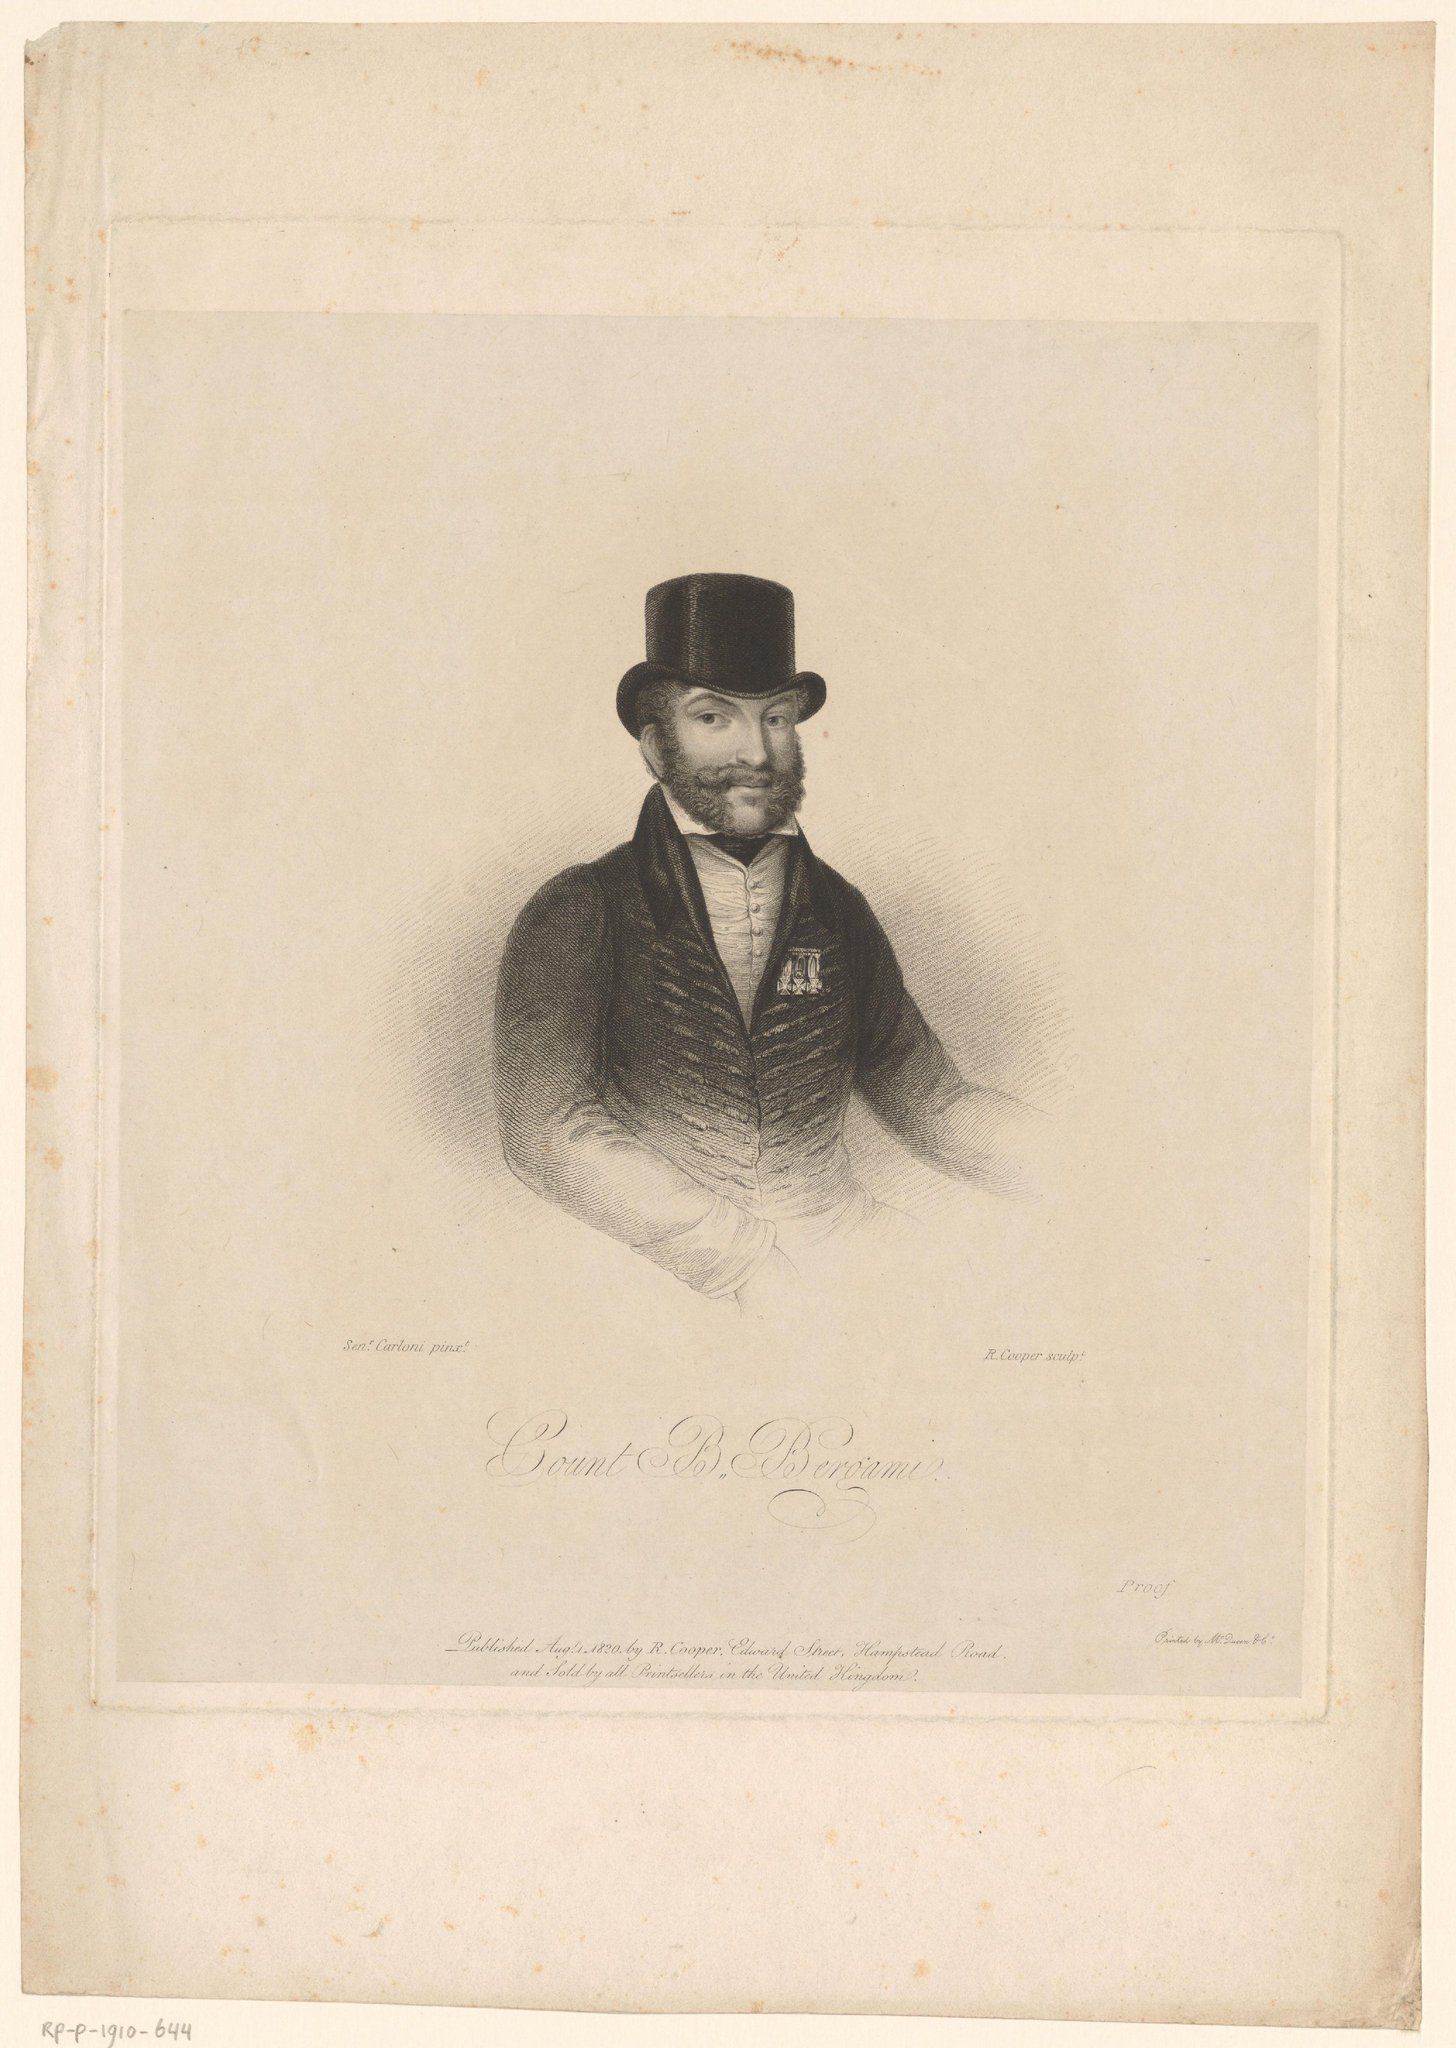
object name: print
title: Portret van Bartolomeo Bergami met hoed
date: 1820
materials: paper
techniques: etching, roulette, engraving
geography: england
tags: earl, historical persons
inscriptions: collector's mark: Lugt 2228